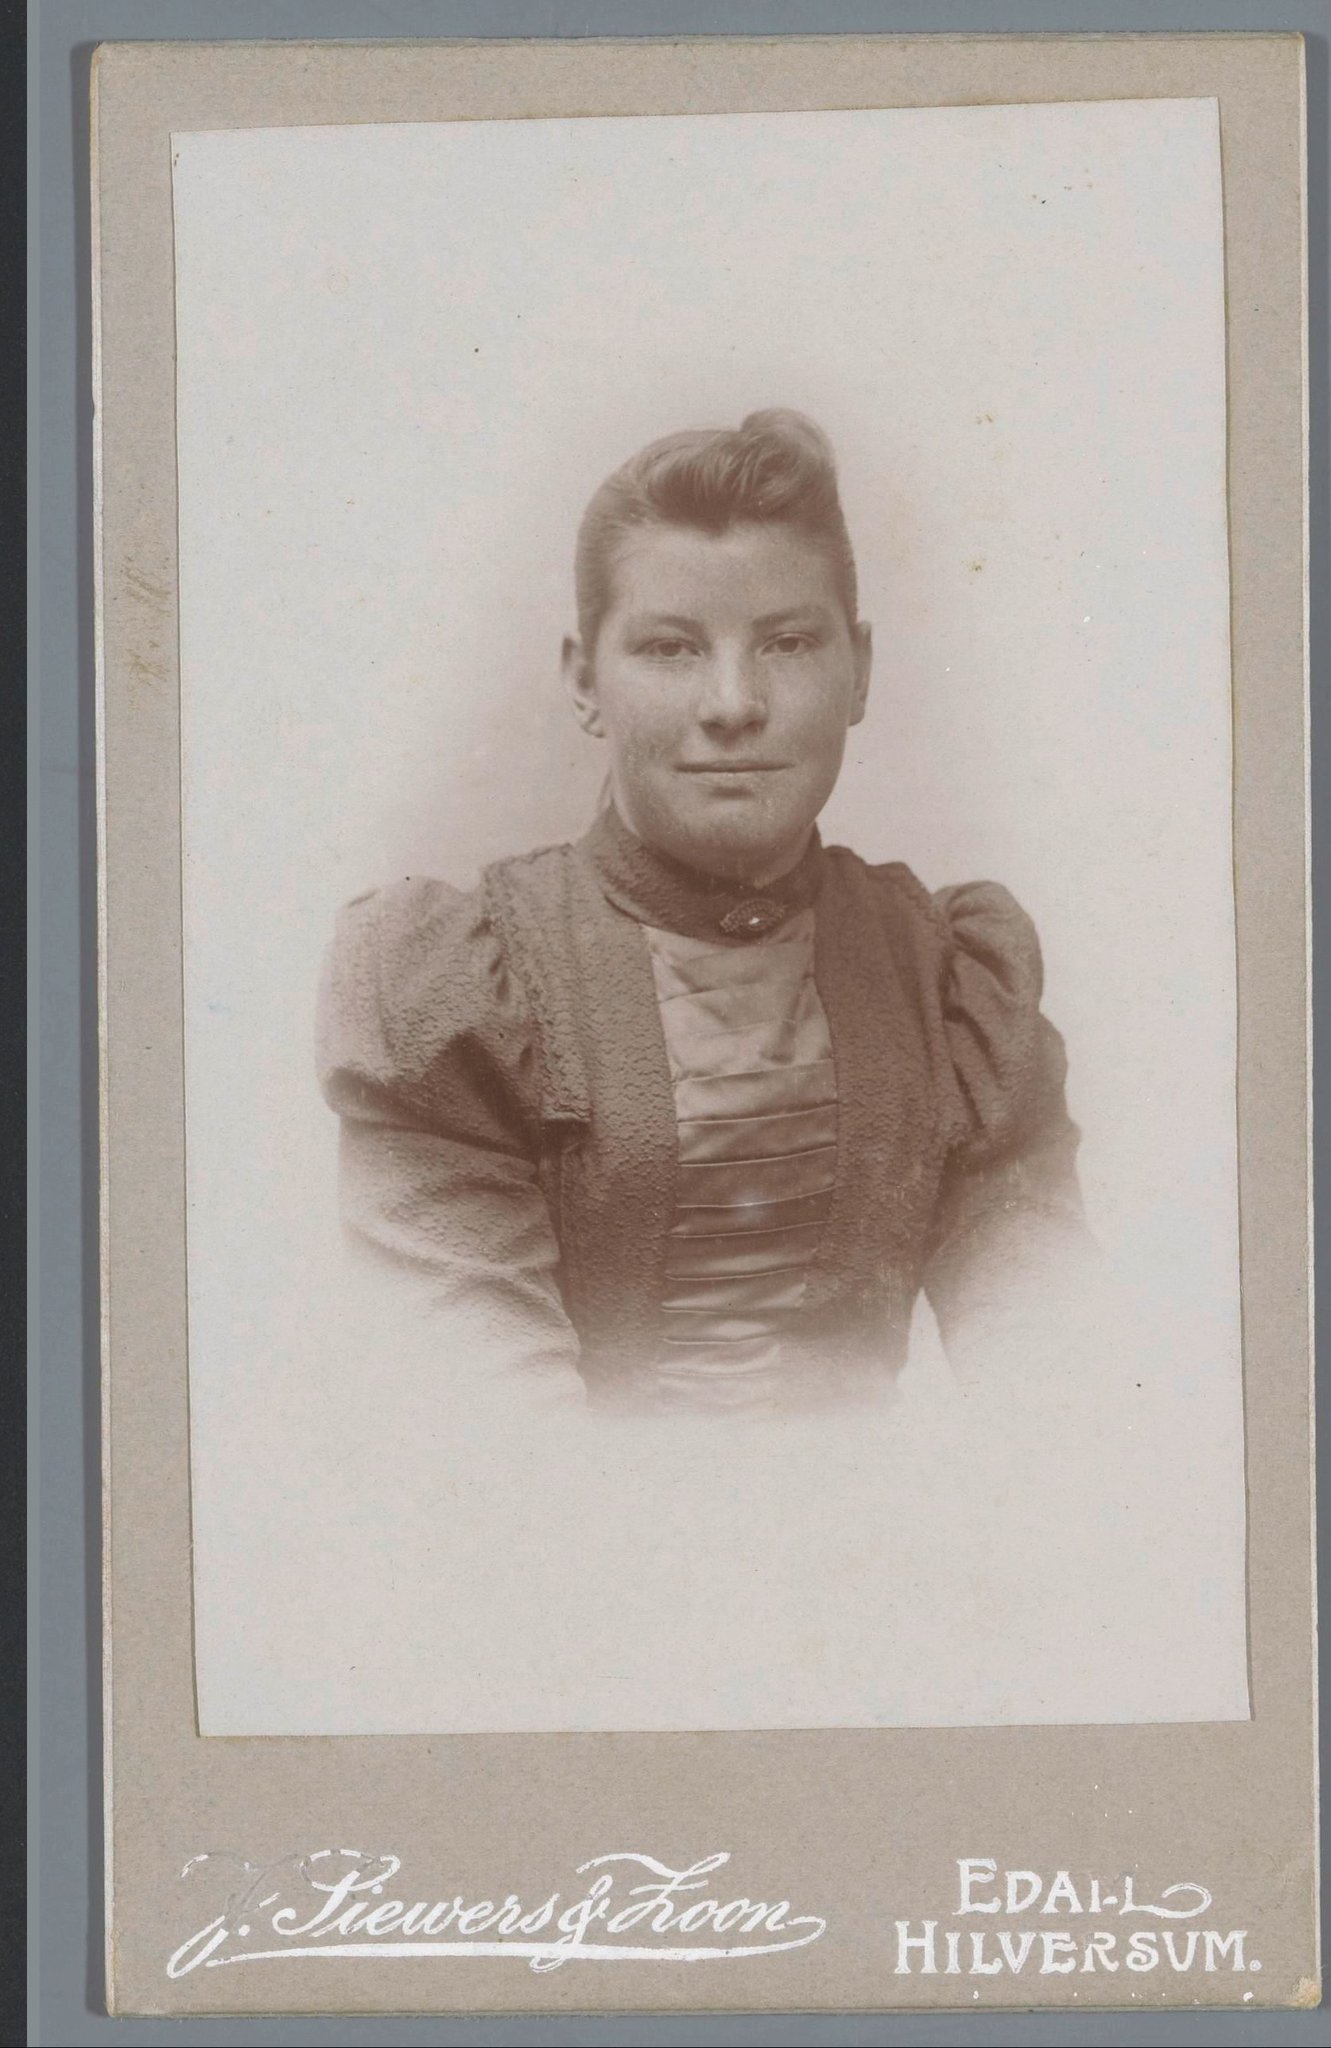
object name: photograph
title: Portret van een onbekende vrouw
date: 1890-1918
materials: cardboard, photographic support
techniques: collodion silver print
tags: historical persons - bb - woman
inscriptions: inscription: ‘Photographische/ ATELIERS/ J. Siewers & Zoon/ EDAM/ HILVERSUM./ Specialiteit in vergrootingen.’